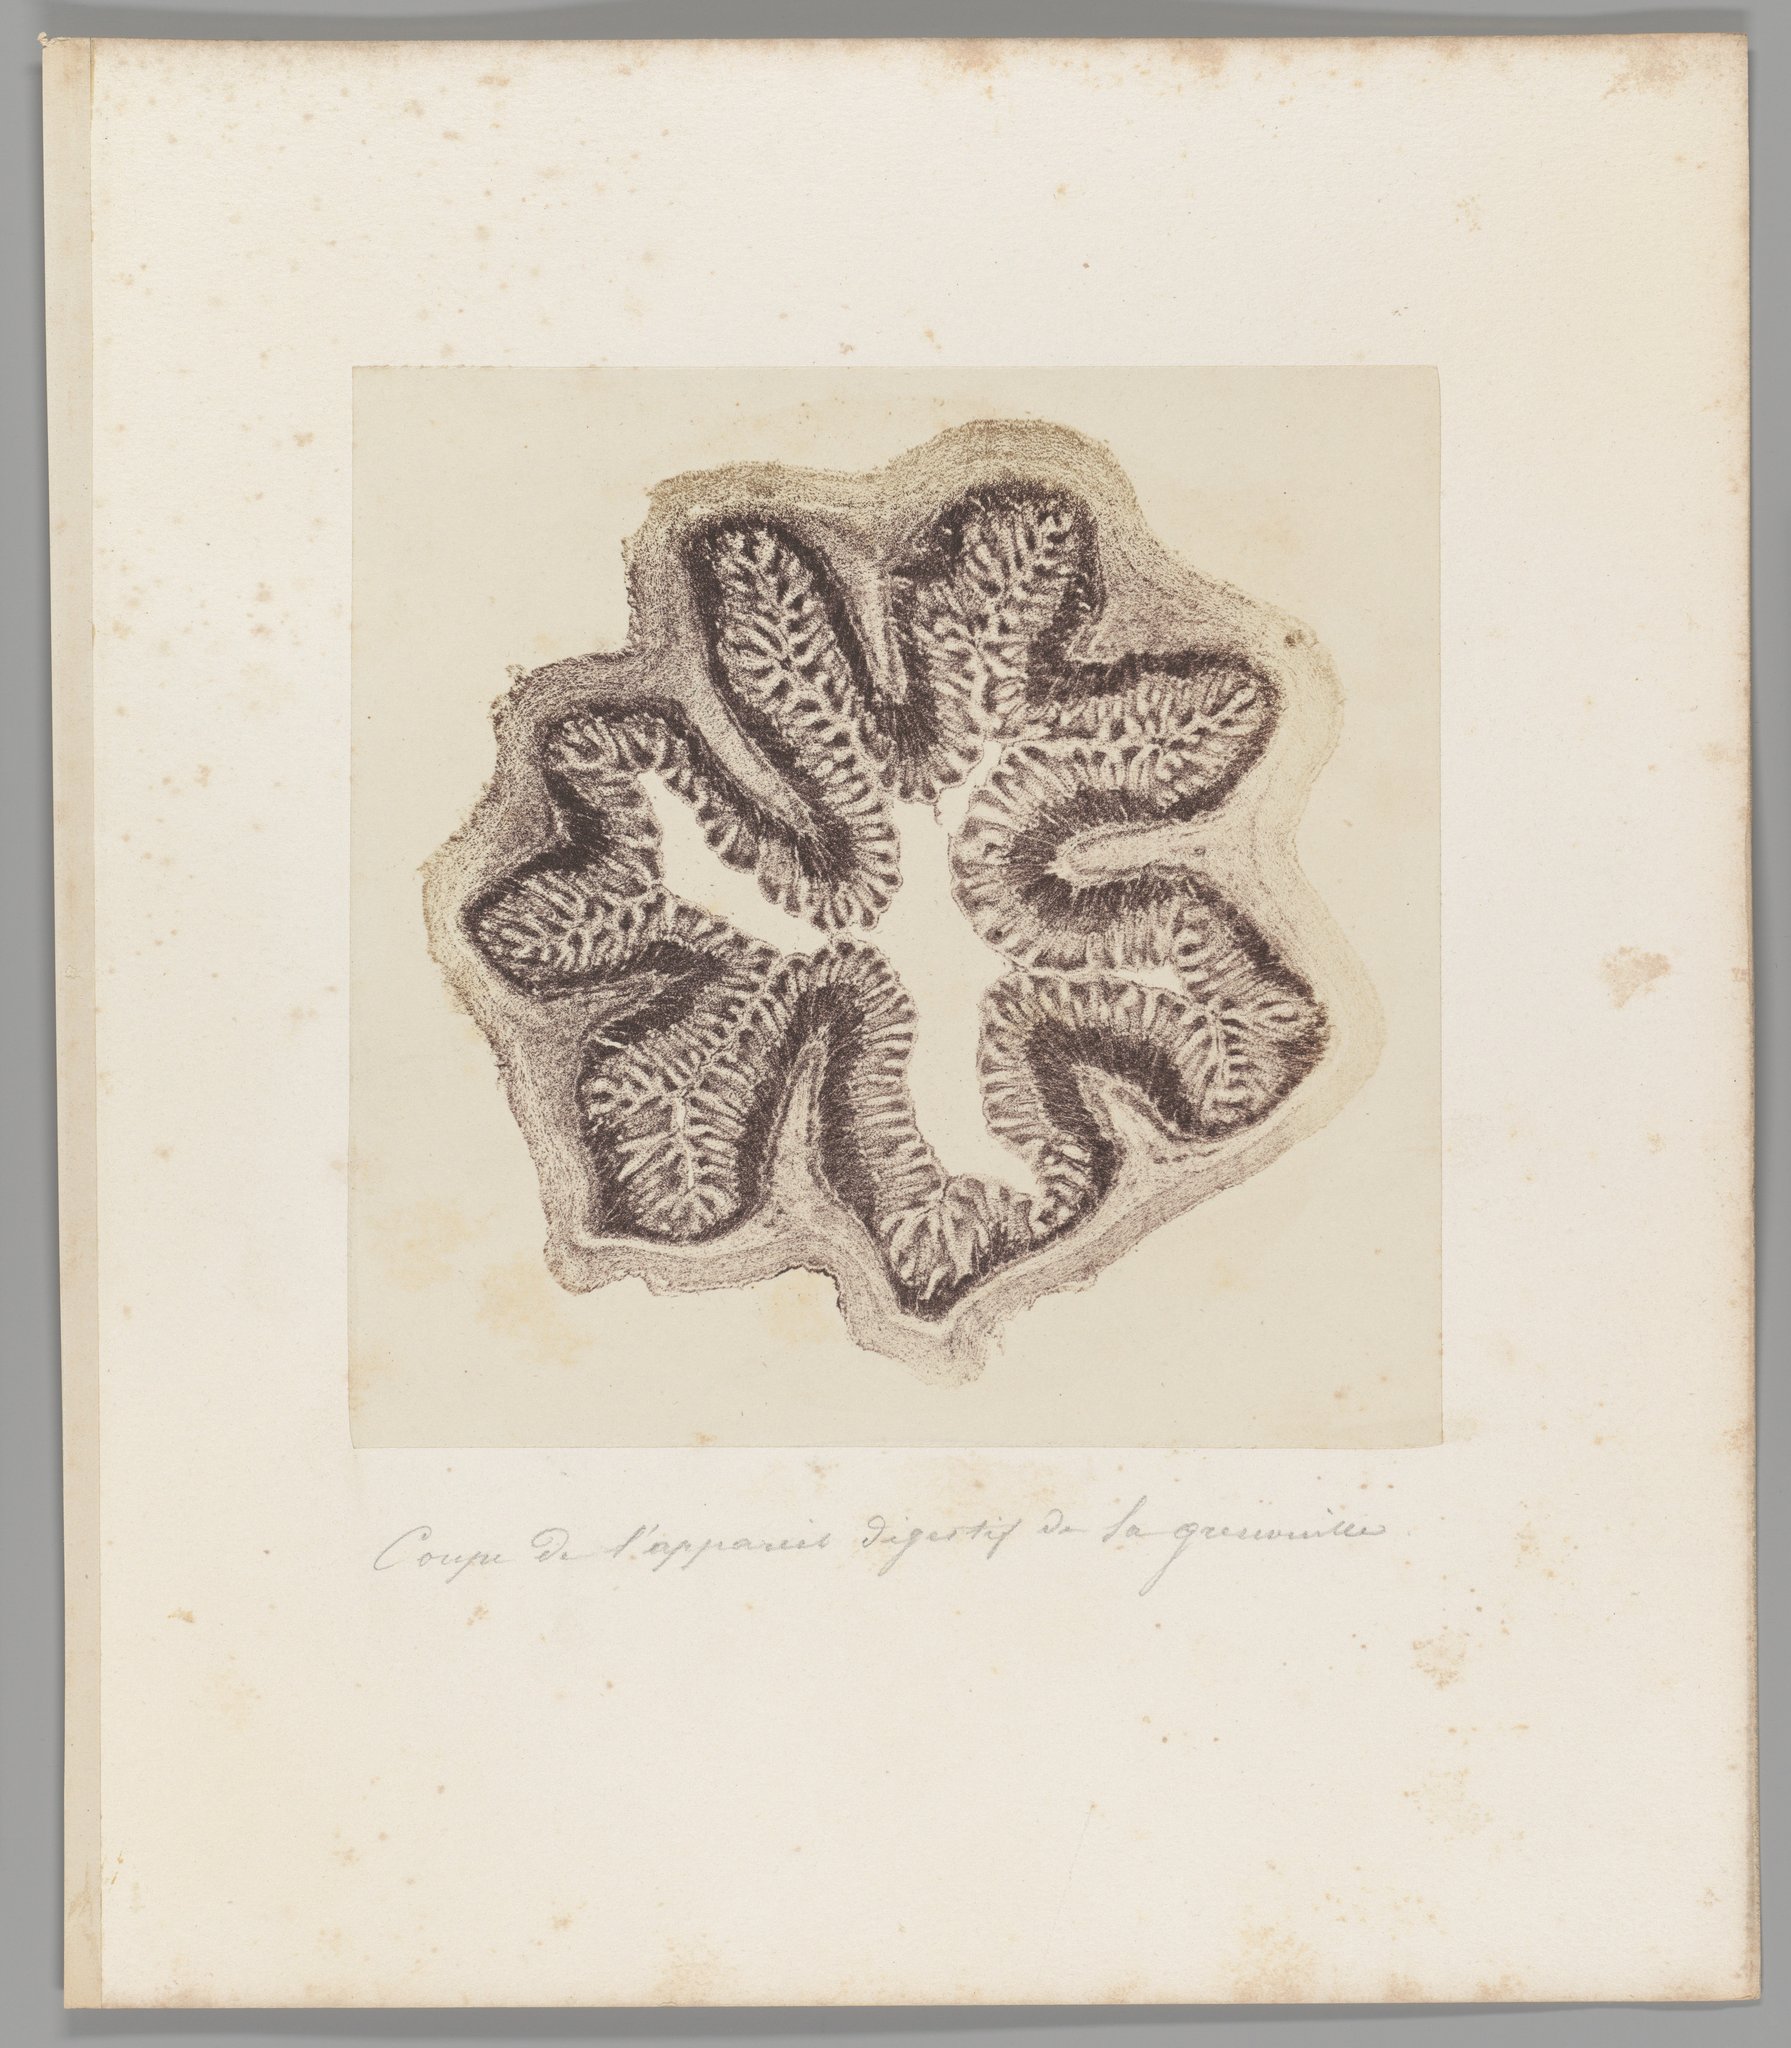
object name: photograph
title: [Untitled]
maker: auguste-adolphe bertsch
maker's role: artist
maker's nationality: french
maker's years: 1813-1871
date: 1853-1857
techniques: salted paper print